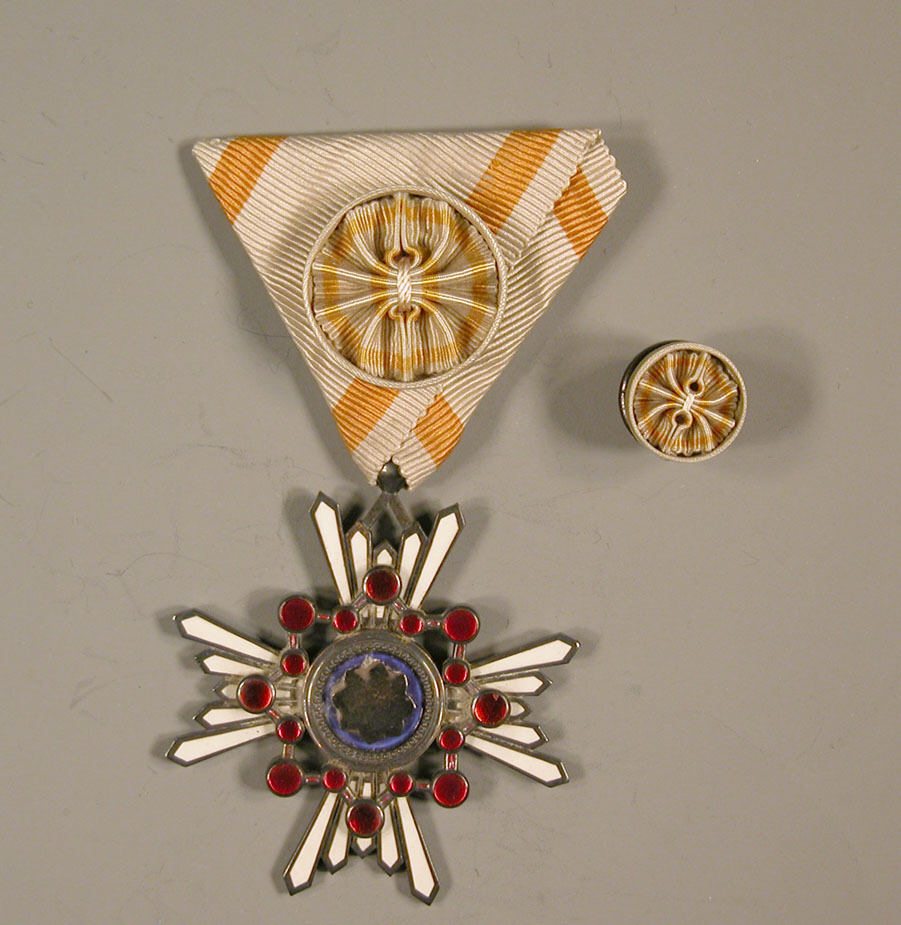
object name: medal and button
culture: japanese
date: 1867-1900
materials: ribbon